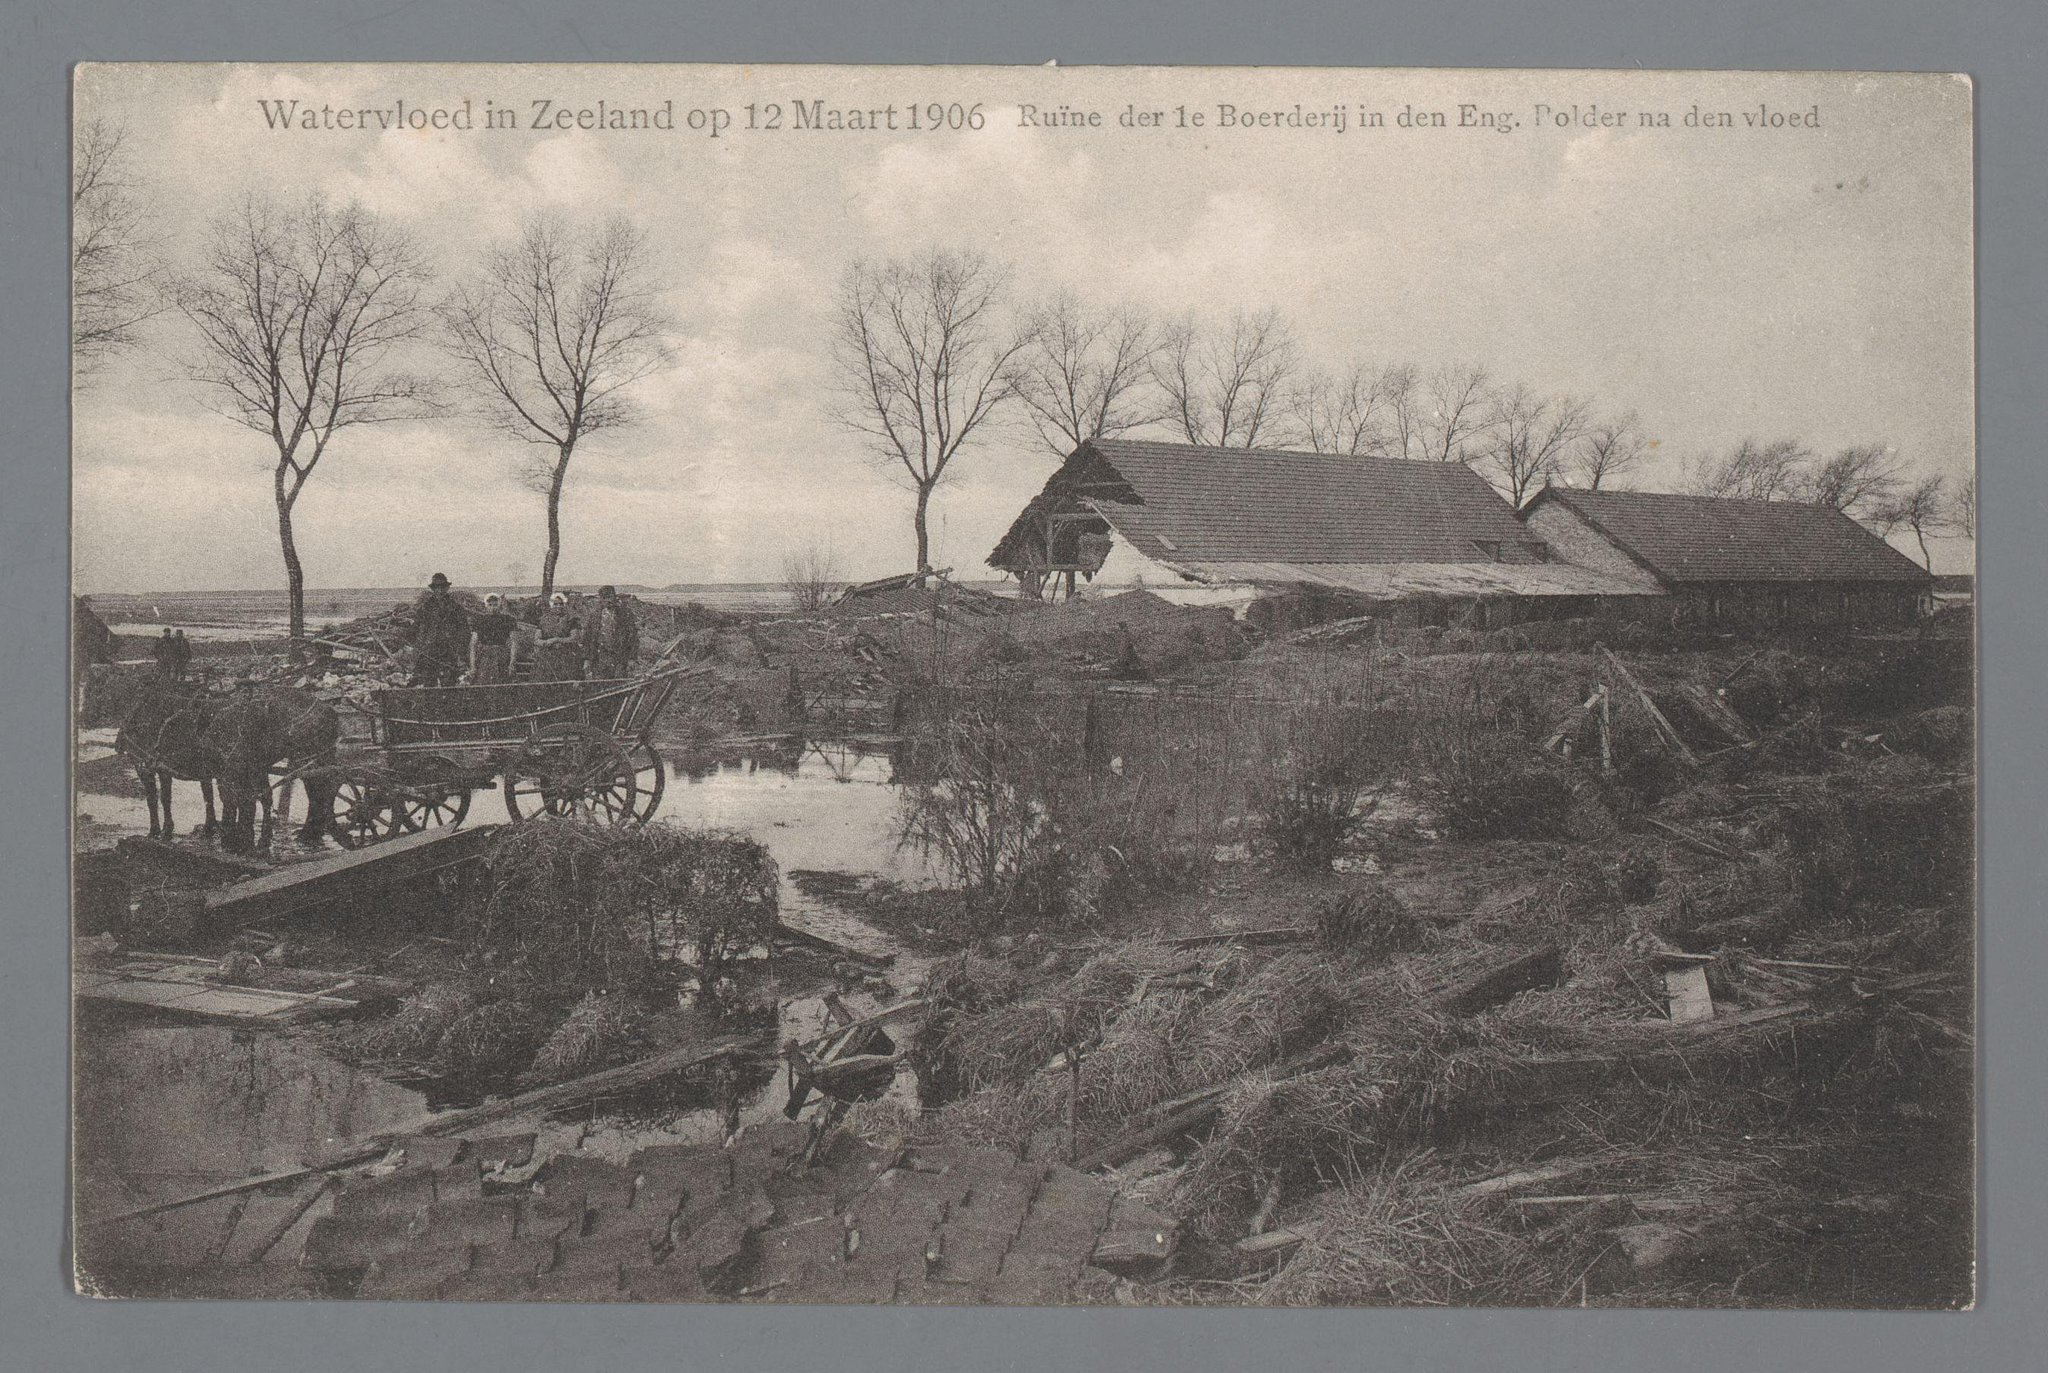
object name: ansichtkaart, prentbriefkaart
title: Watervloed in Zeeland op 12 maart 1906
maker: p.j. daniëlse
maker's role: publisher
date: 1906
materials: paper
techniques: printing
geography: middelburg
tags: zeeland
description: Briefkaart, zwart-wit. Watersnood 12 maart 1906, Zeeland.